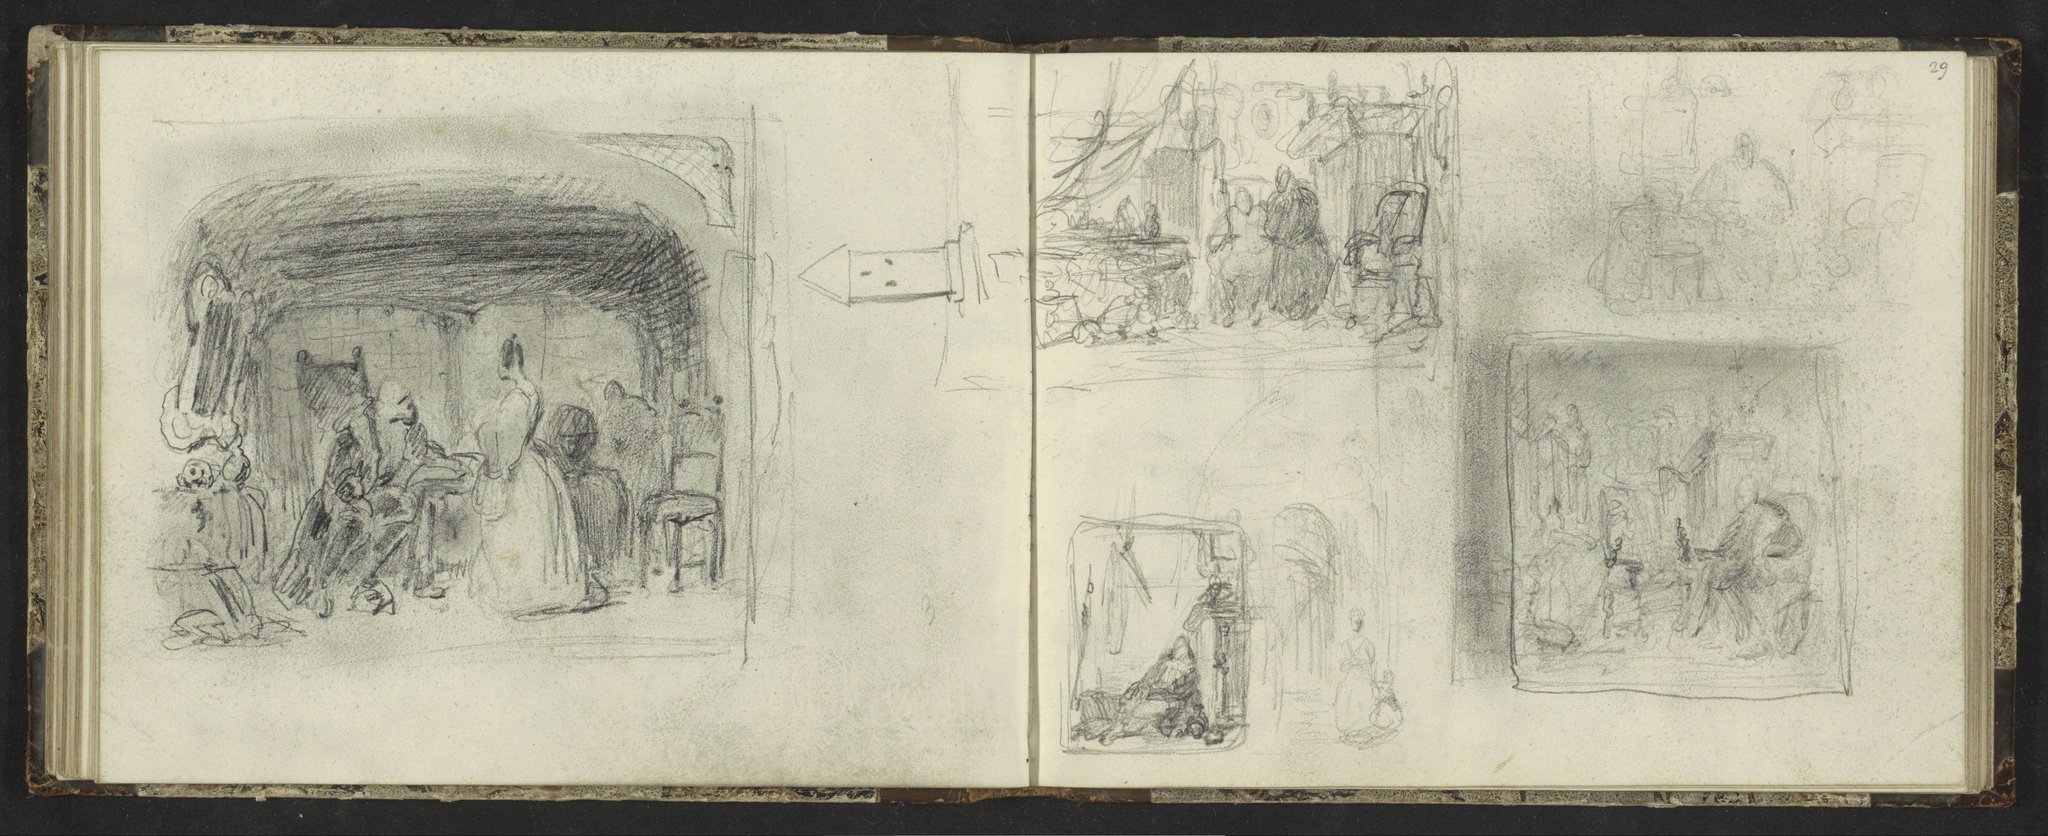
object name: sketchbook leaf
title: Interieurs met figuren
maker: willem hendrik schmidt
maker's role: draughtsman, painter, print maker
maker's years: 1809-1849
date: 1819-1849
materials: paper, pencil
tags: interior of the house, tower (of house or building), street (+ city(-scape) with figures, staffage)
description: Studies van (boeren)interieurs met figuren, een straatscène en een toren. Tekeningen in kaders. Mogelijk gaat het om voorstudies voor schilderijen of studies naar schilderijen. Blad 28 verso en 29 recto uit een schetsboek met 58 bladen.